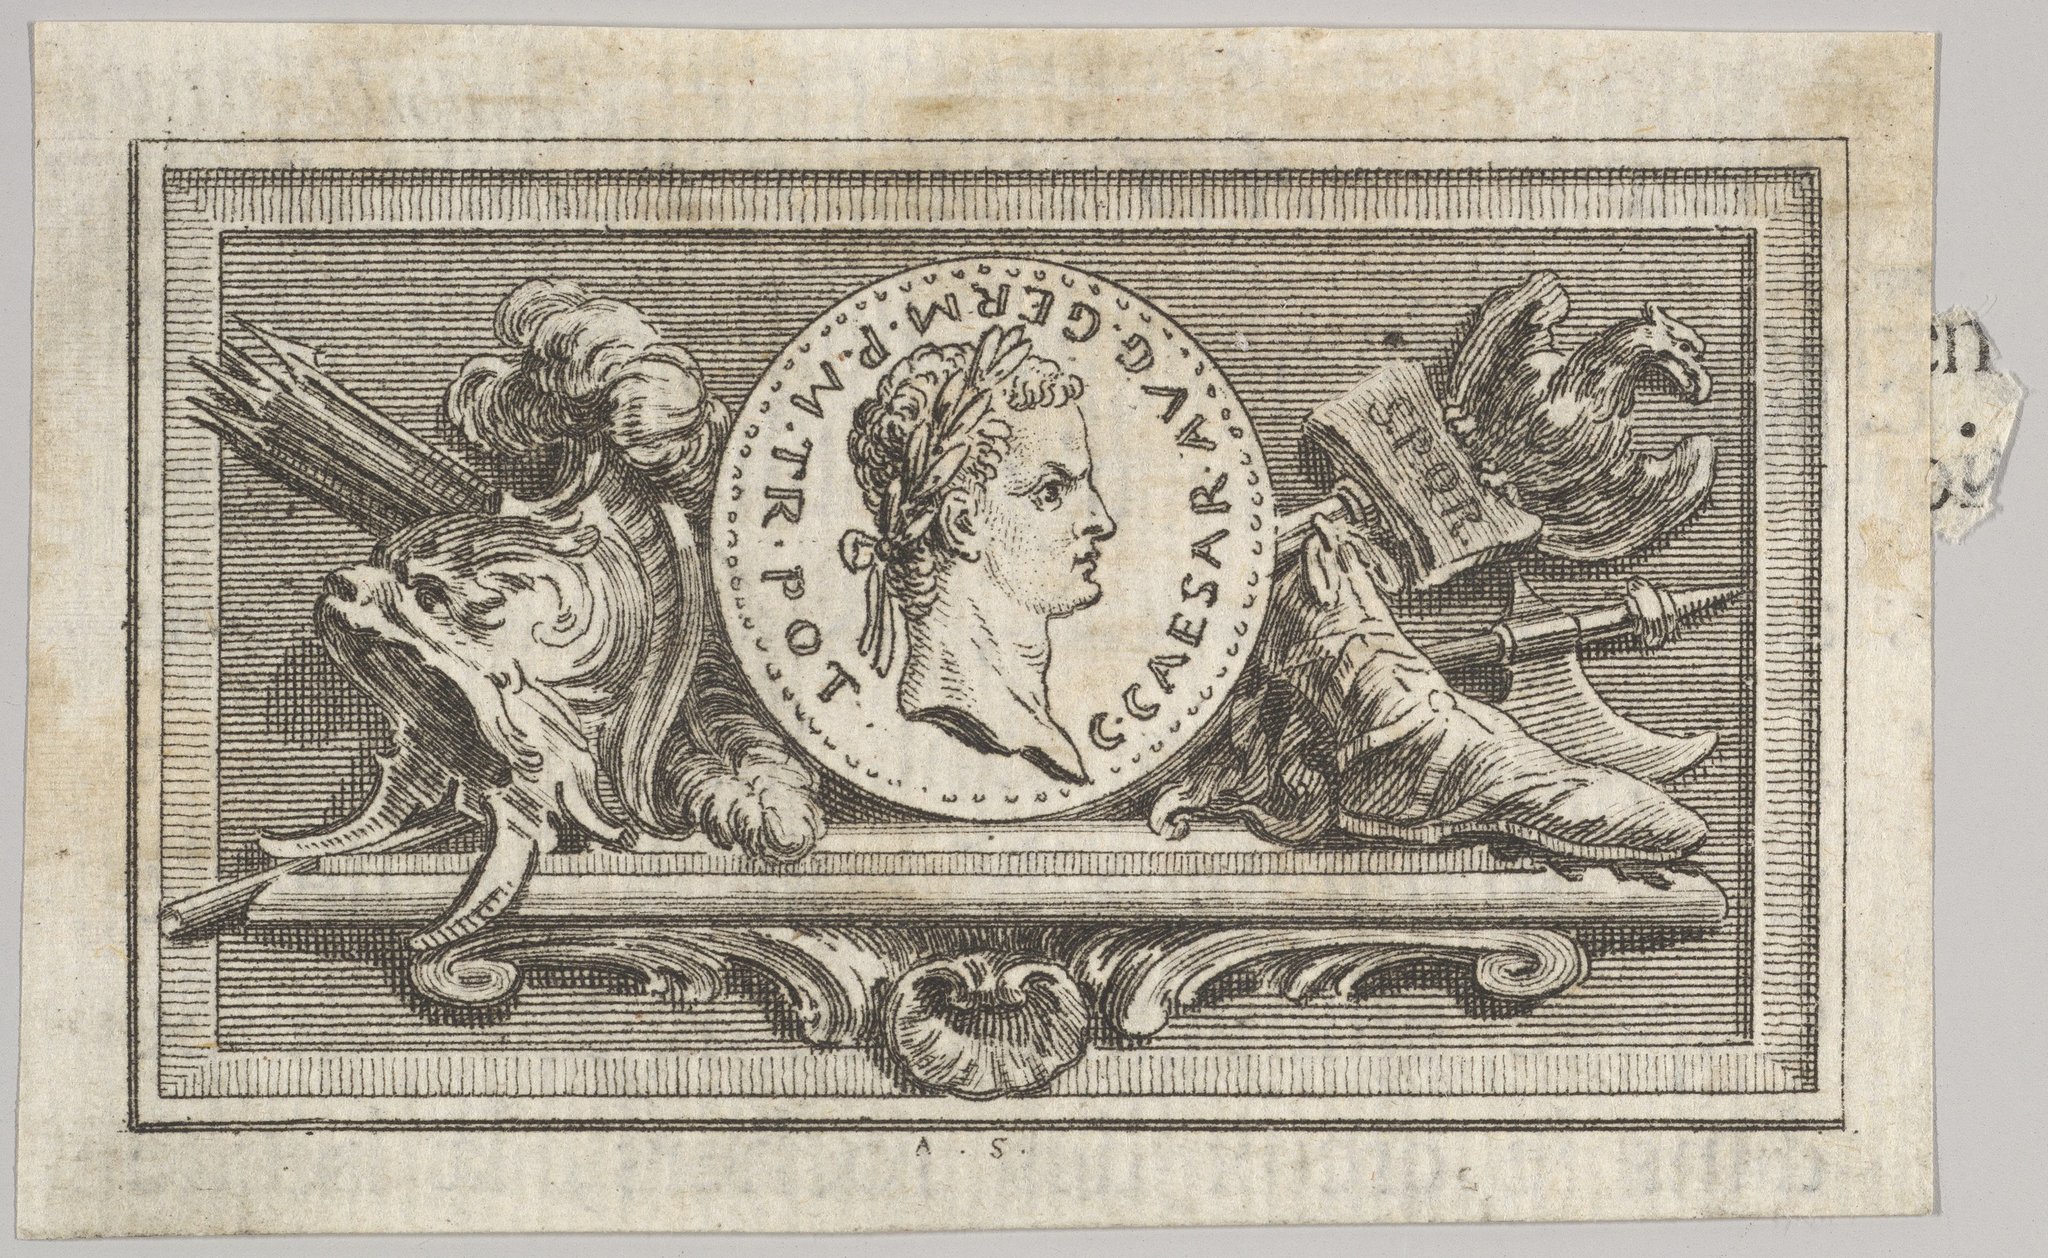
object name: print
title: Medal with Portrait of Caligula in the 6th Book, from Tibère ou les six premiers livres es Annales de Tacite Traduits par M. l'abbé de la Bléterie Professeur d'Eloquence au Collège Royal et de l'Académie Royale des Inscriptions et Belles-lettres. A Paris de l'Imprimerie Royale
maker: augustin de saint-aubin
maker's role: artist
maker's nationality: french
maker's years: 1736-1807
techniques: engraving, etching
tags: animals,birds,men,profiles